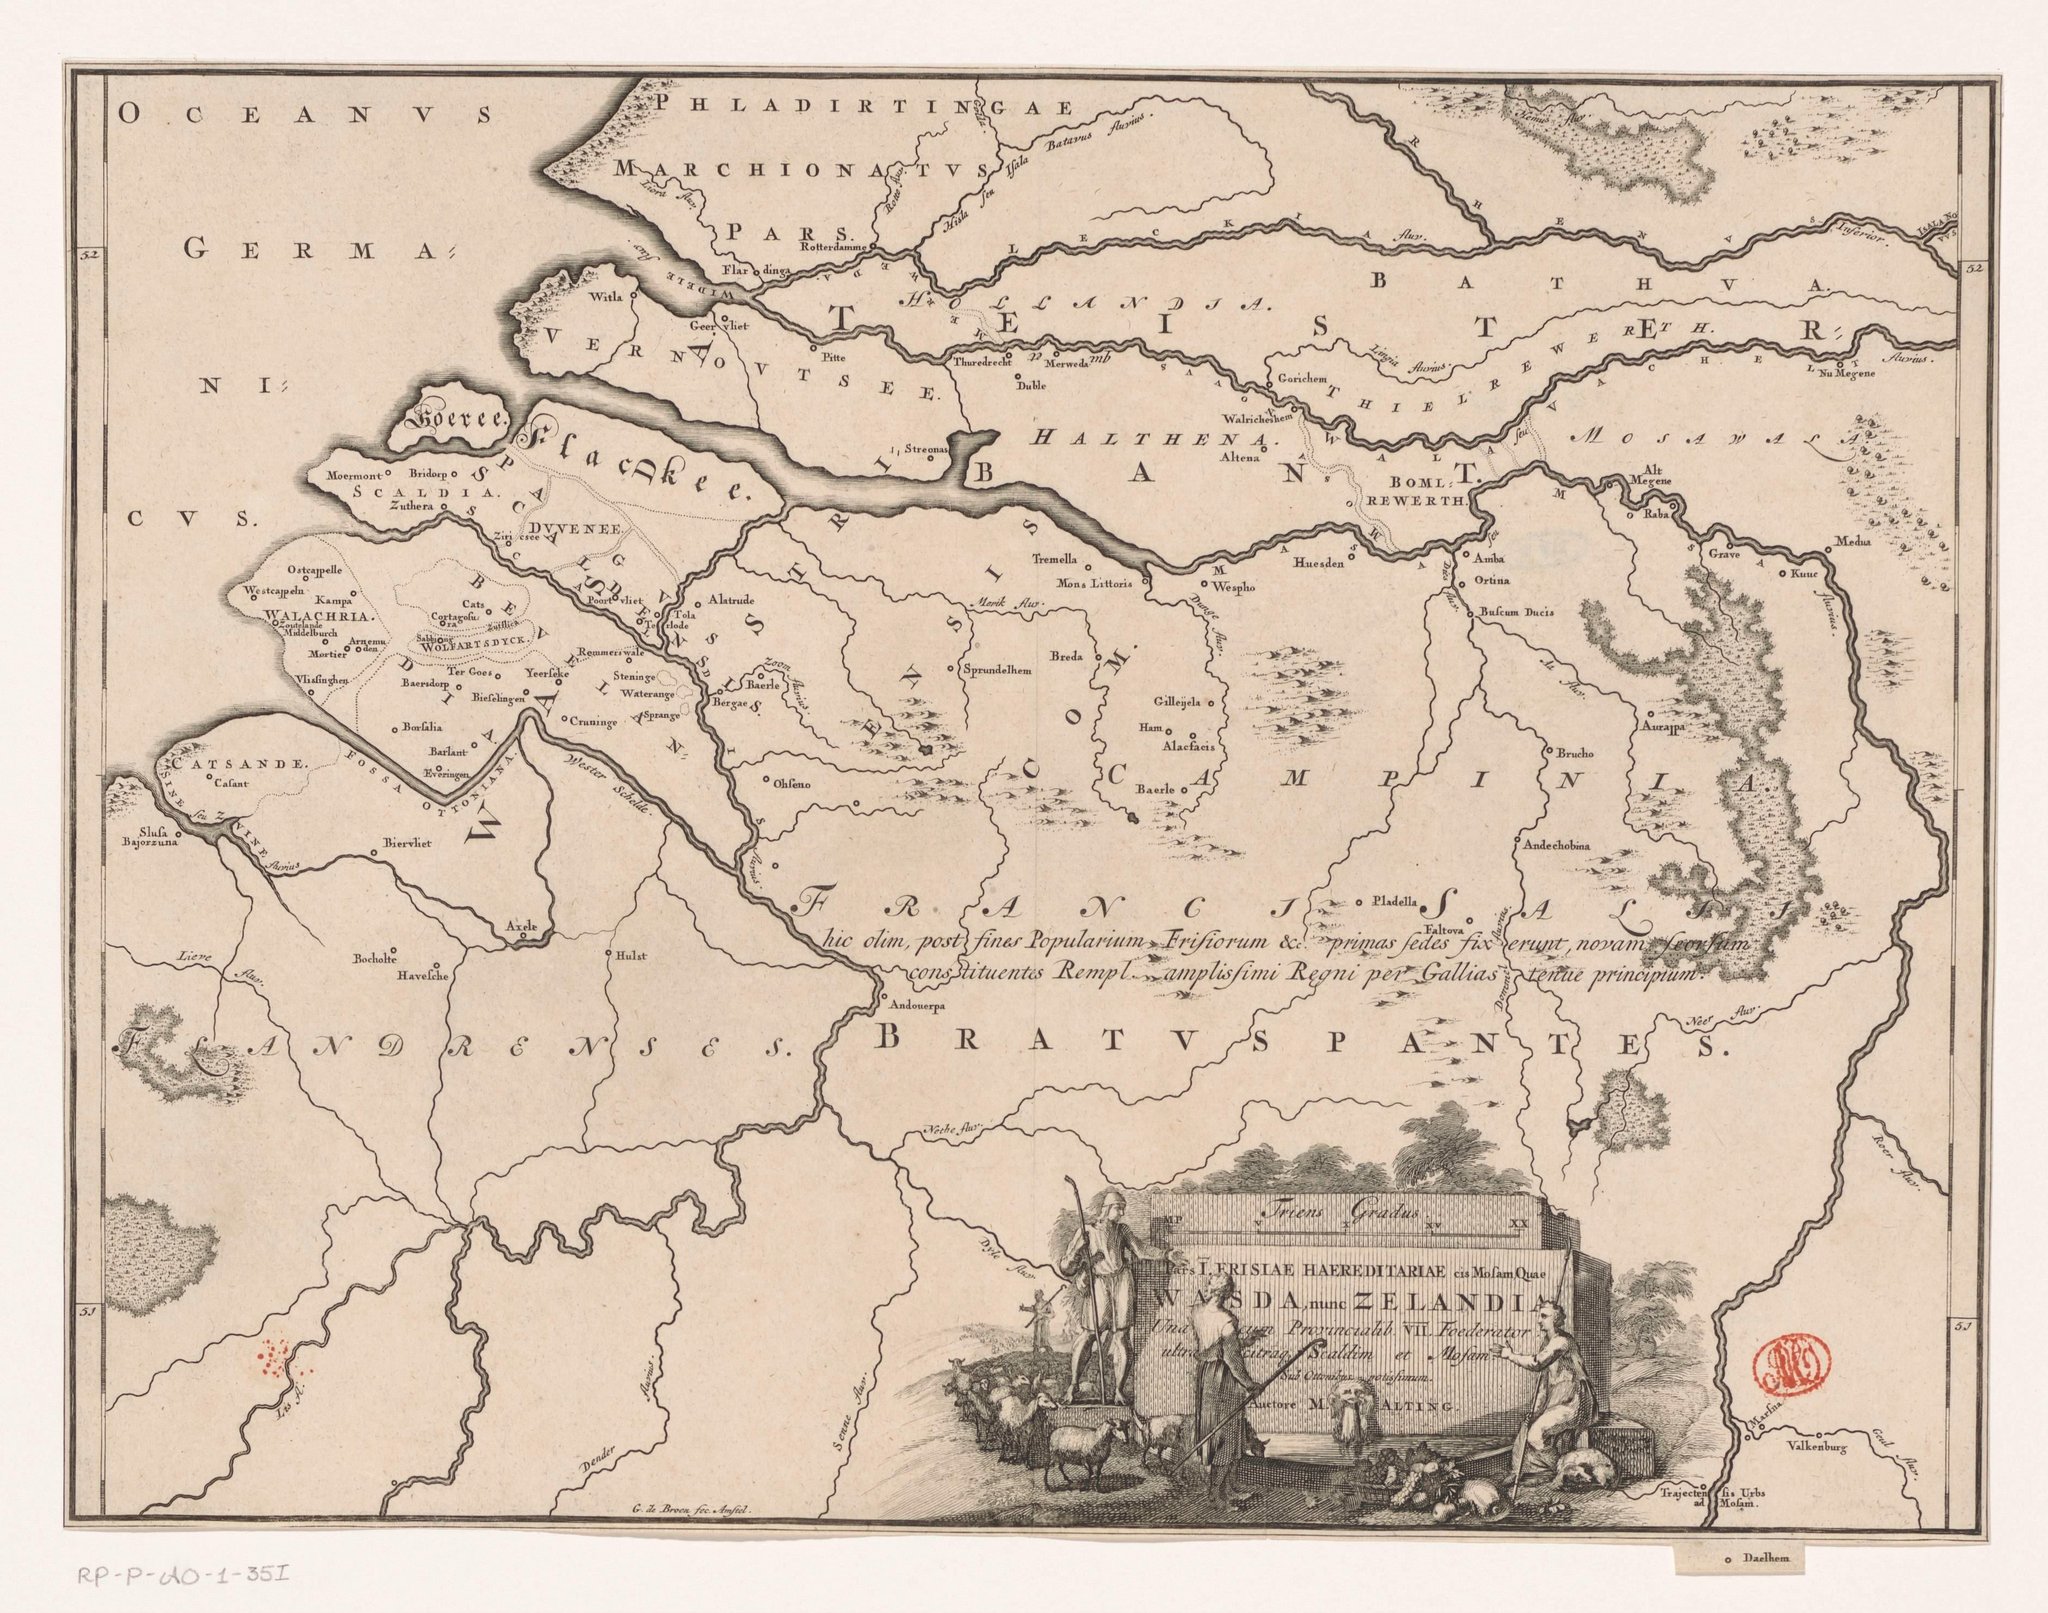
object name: map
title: Historische kaart van Nederland met de gebieden van de Bataven en Friezen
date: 1697-1700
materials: paper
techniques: engraving, etching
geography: amsterdam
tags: maps of separate countries or regions, herding, herdsman, herdswoman, shepherd, shepherdess, cowherd, etc., netherlands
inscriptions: collector's mark: Lugt 2228, collector's mark: Lugt 195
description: Maakt deel uit van 16 kaarten van het land van de Bataven en de Friezen eerst vervaardigd voor en opgenomen in Alting, Menso. Descriptio, secundum antiquos, agri Batavi & Frisii. 2 delen. Amsterdam: Henricus Wetstein, 1697-1700. Hergebruikt in Halma, François. Tooneel der Vereenigde Nederlanden, en onderhorige landschappen (...). 2 delen. Leeuwarden: Hendrik Halma, 1725. Deze kaart is gebruikt in Halma's Tooneel der Vereenigde Nederlanden (1725) en is waarschijnlijk te vinden in deel 2, p. 292.